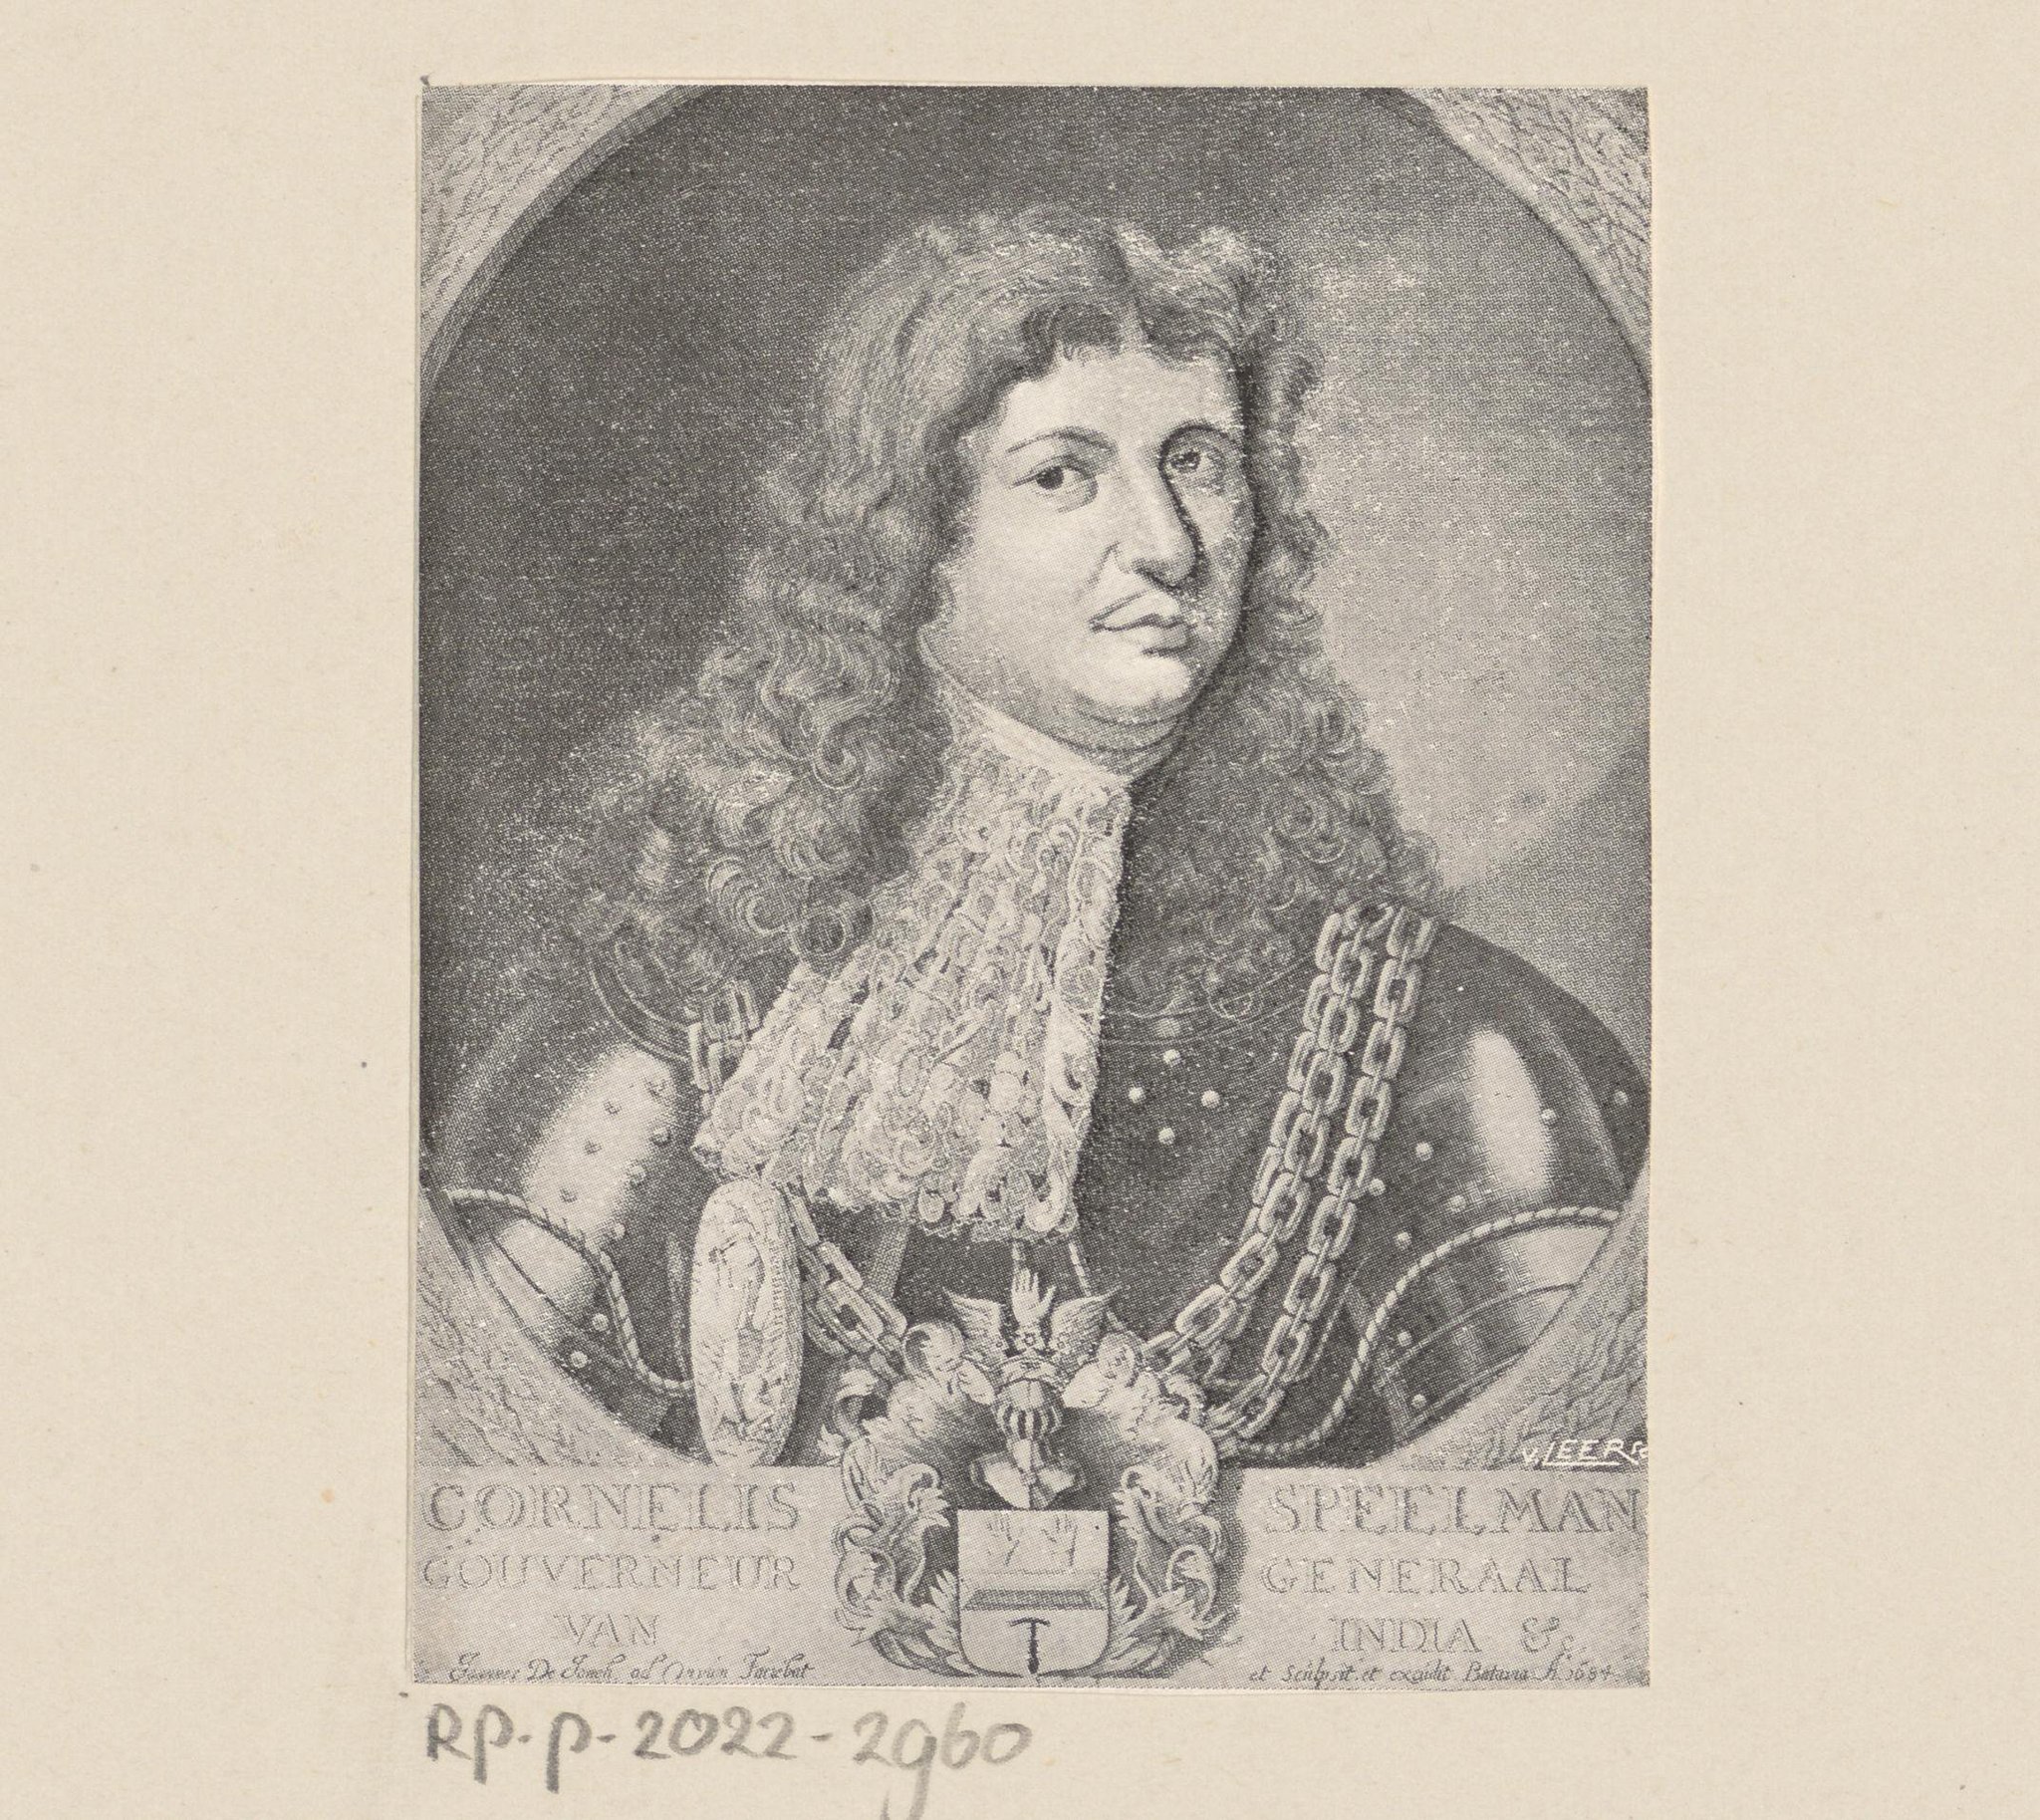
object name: photomechanical print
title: Portret van Cornelis Speelman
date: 1870-1966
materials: paper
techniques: autotype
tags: rotterdam, batavia, colonial governor, historical persons